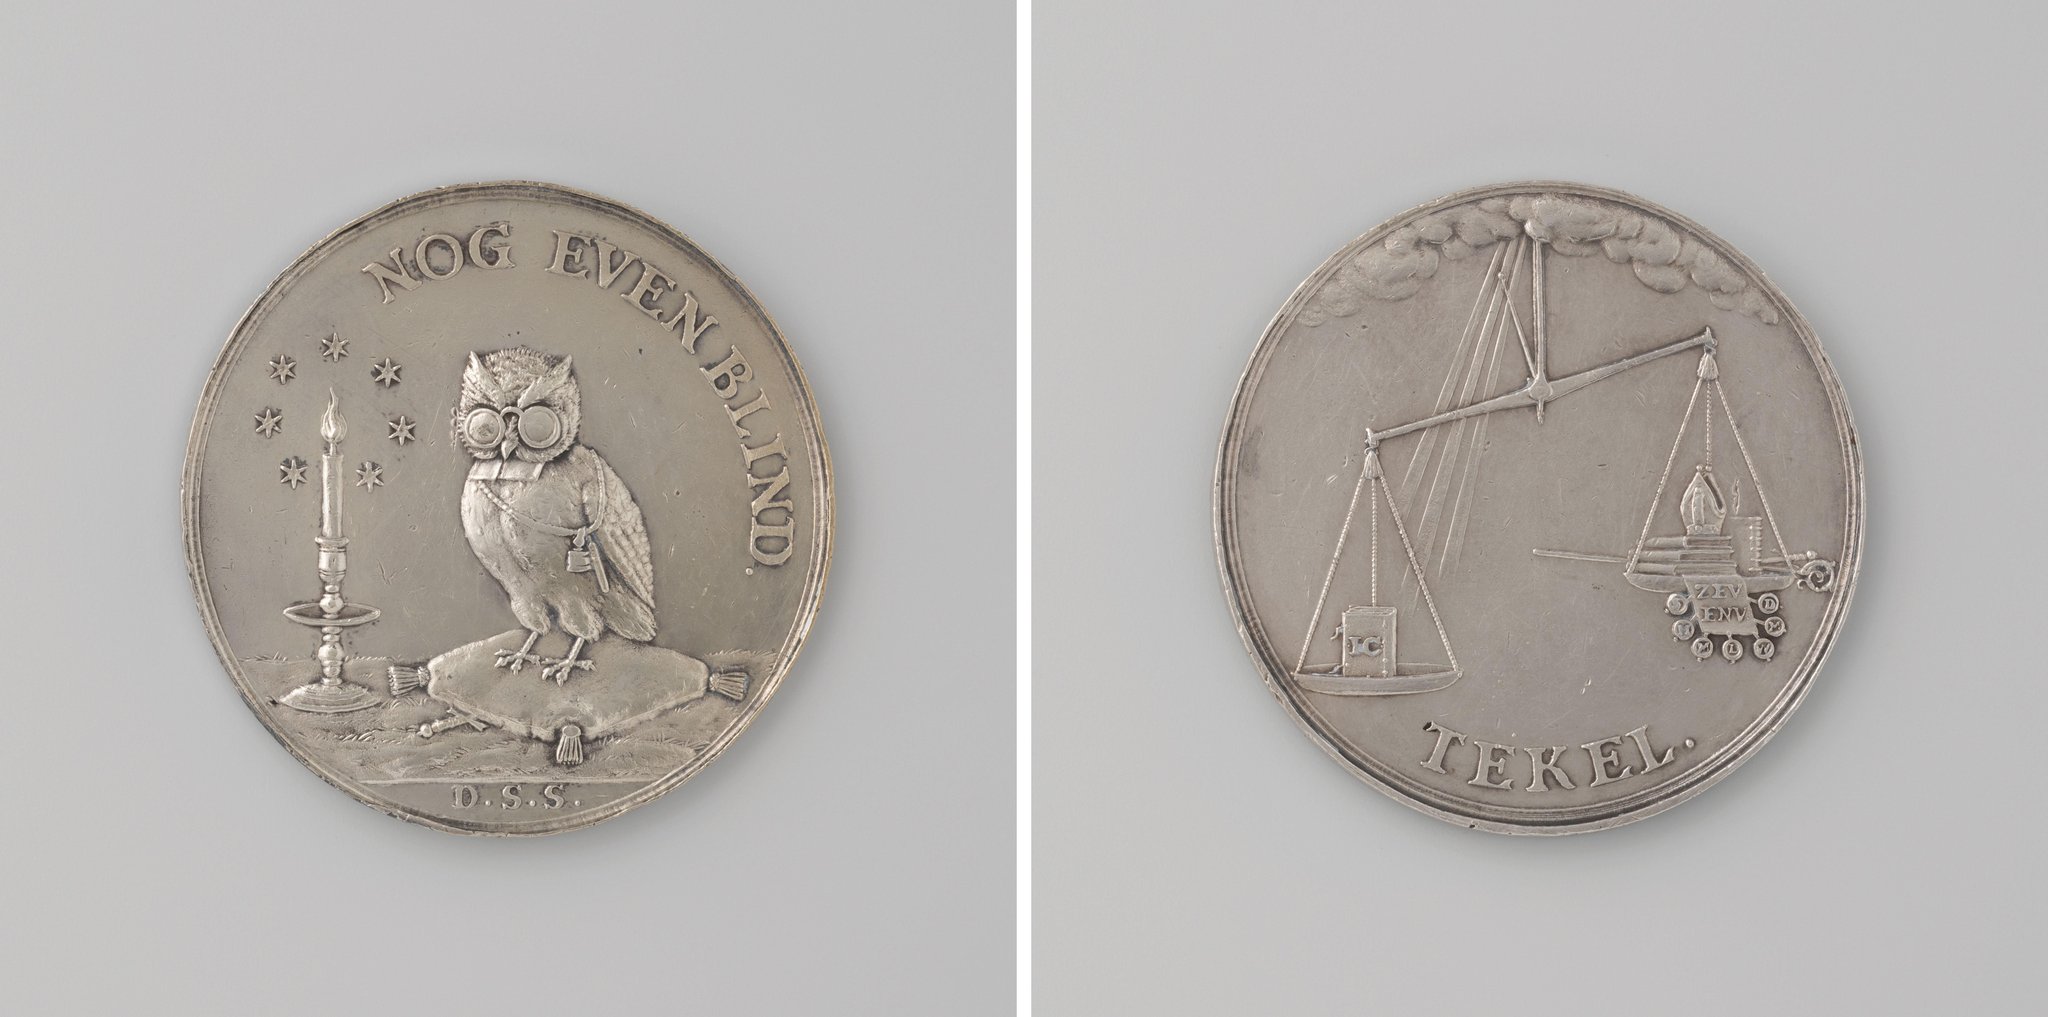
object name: satirical medal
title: Anti-katholieke spotpenning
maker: monogrammist dss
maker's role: medailleur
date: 1685-1688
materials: silver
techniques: striking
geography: netherlands